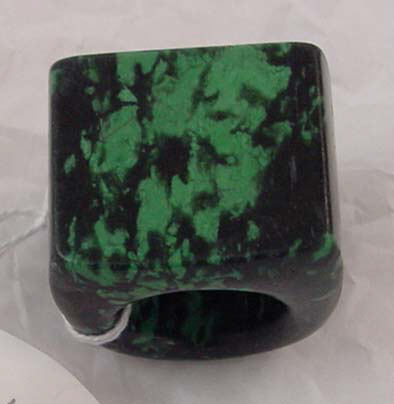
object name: ring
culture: chinese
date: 1801-1900